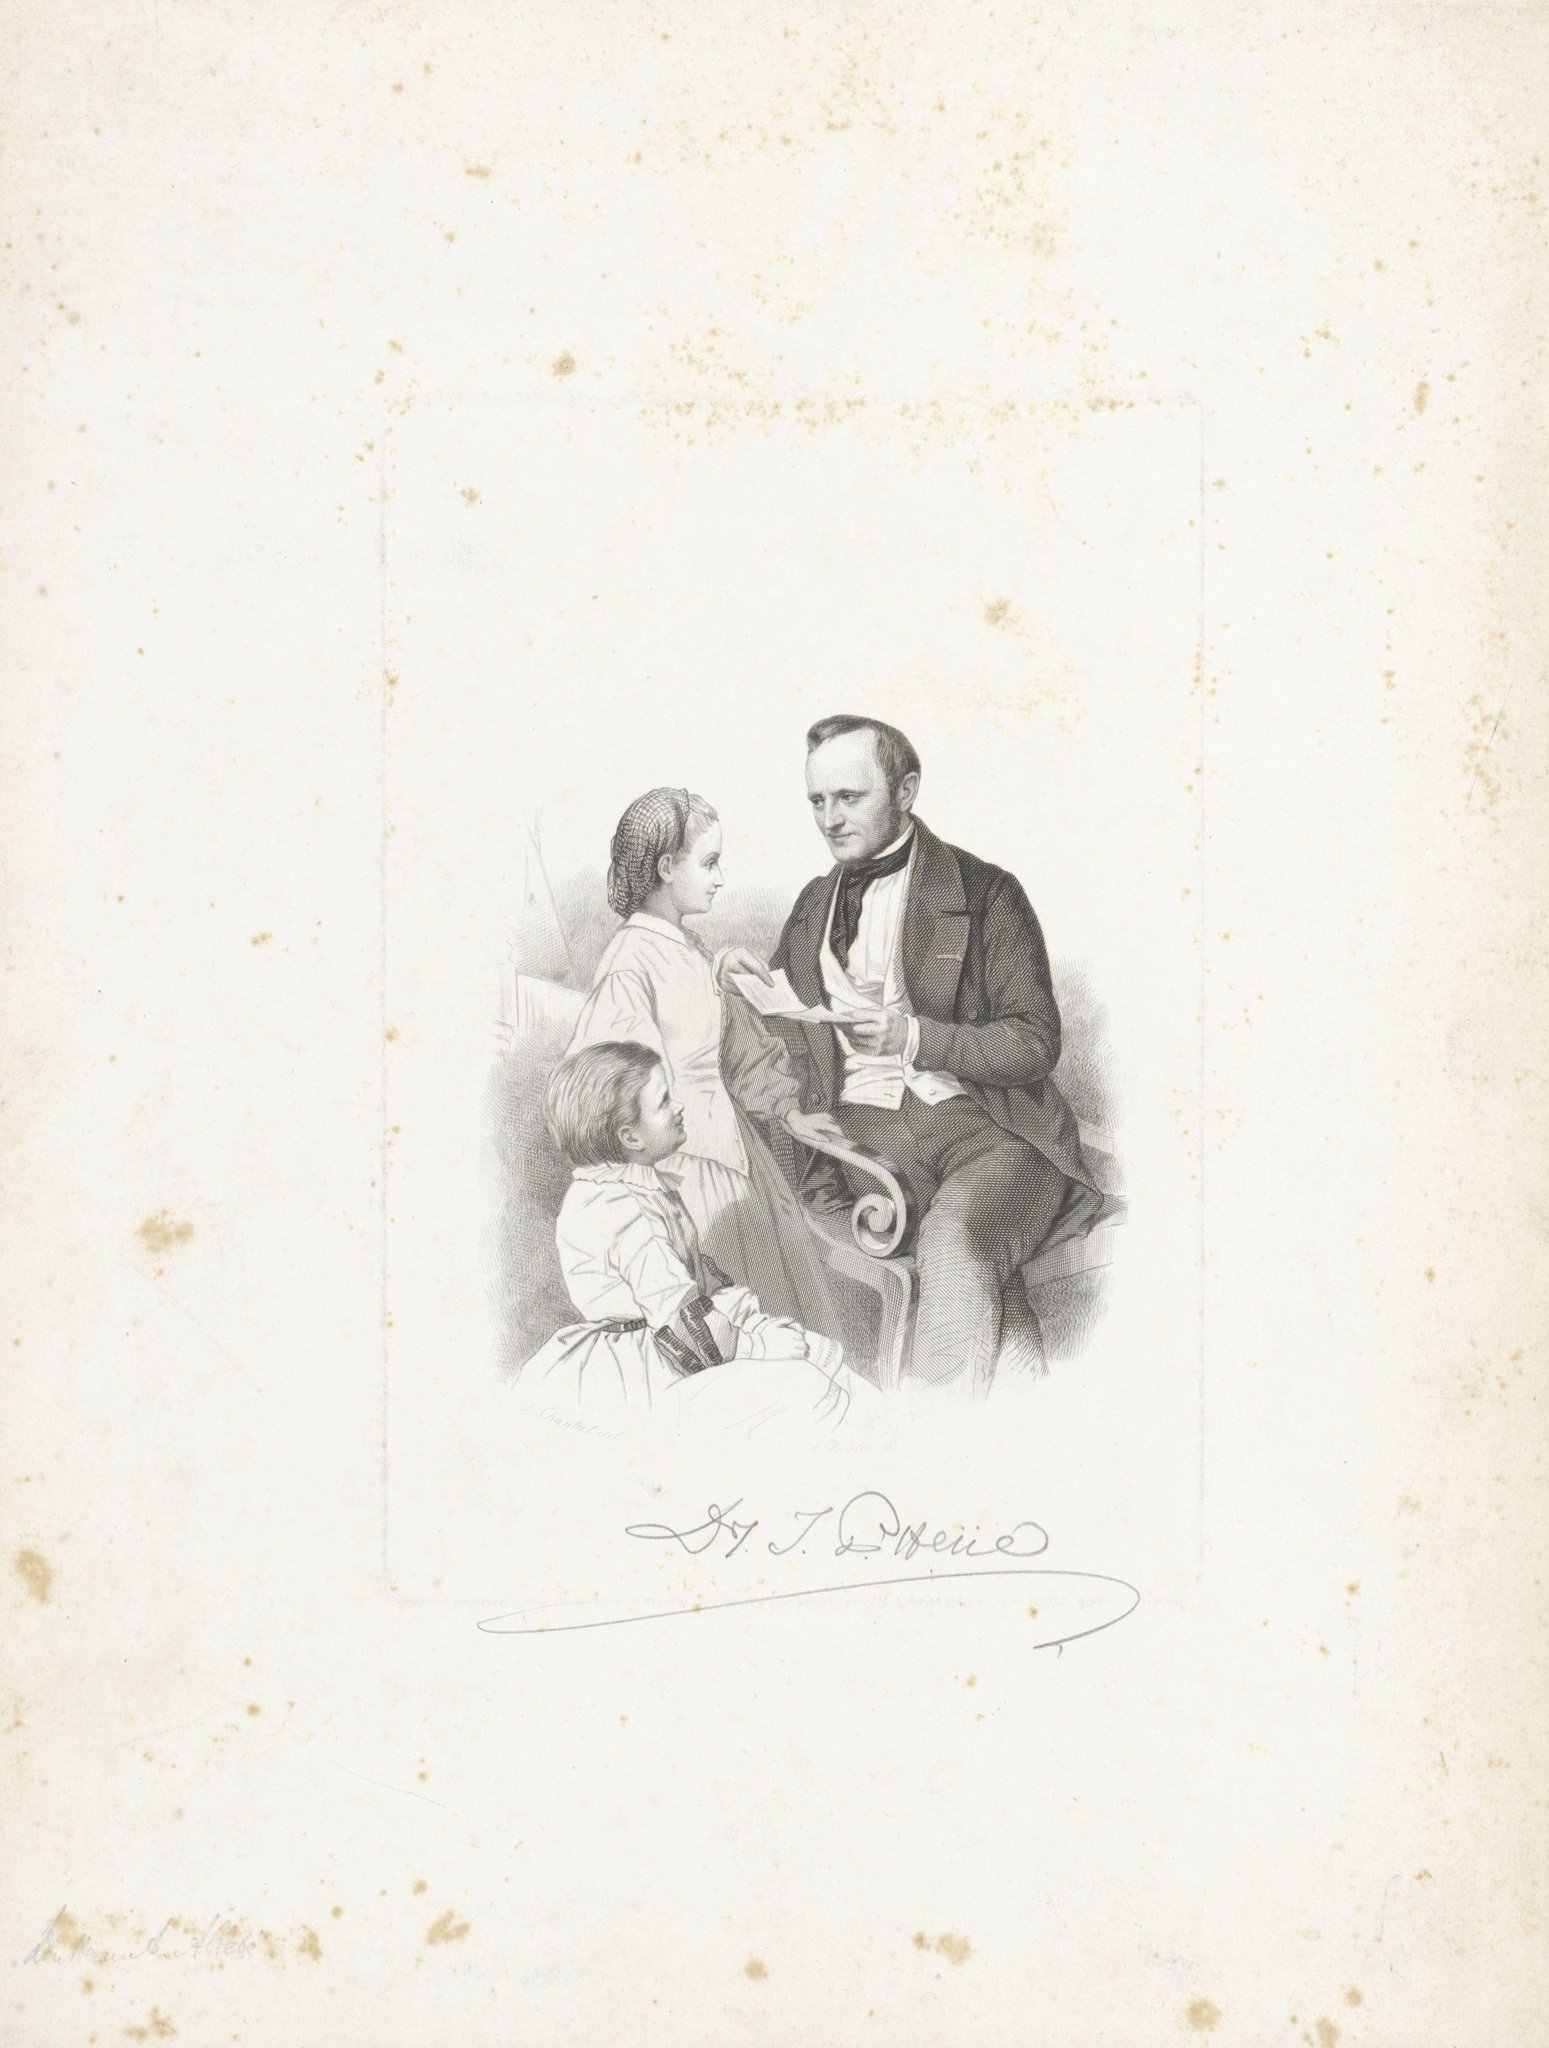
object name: print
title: Titelpagina voor: J.P. Heije, Al de Kinderliederen (...), 1861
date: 1861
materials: paper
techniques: etching, roulette, engraving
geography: amsterdam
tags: reading to somebody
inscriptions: inscription: ‘[?] A. Allebe’, inscription: ‘Au. Allebee’, collector's mark: Lugt 2233, inscription, inscription: ‘Handtekening auteur’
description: Een man op een stoel met een vel beschreven of bedrukt papier in de hand kijkt naar een meisje en een jongen naast hem.